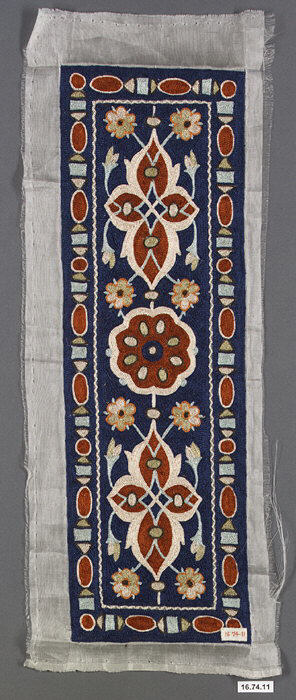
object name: panel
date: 1867-1900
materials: silk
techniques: embroidery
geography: iran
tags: flowers